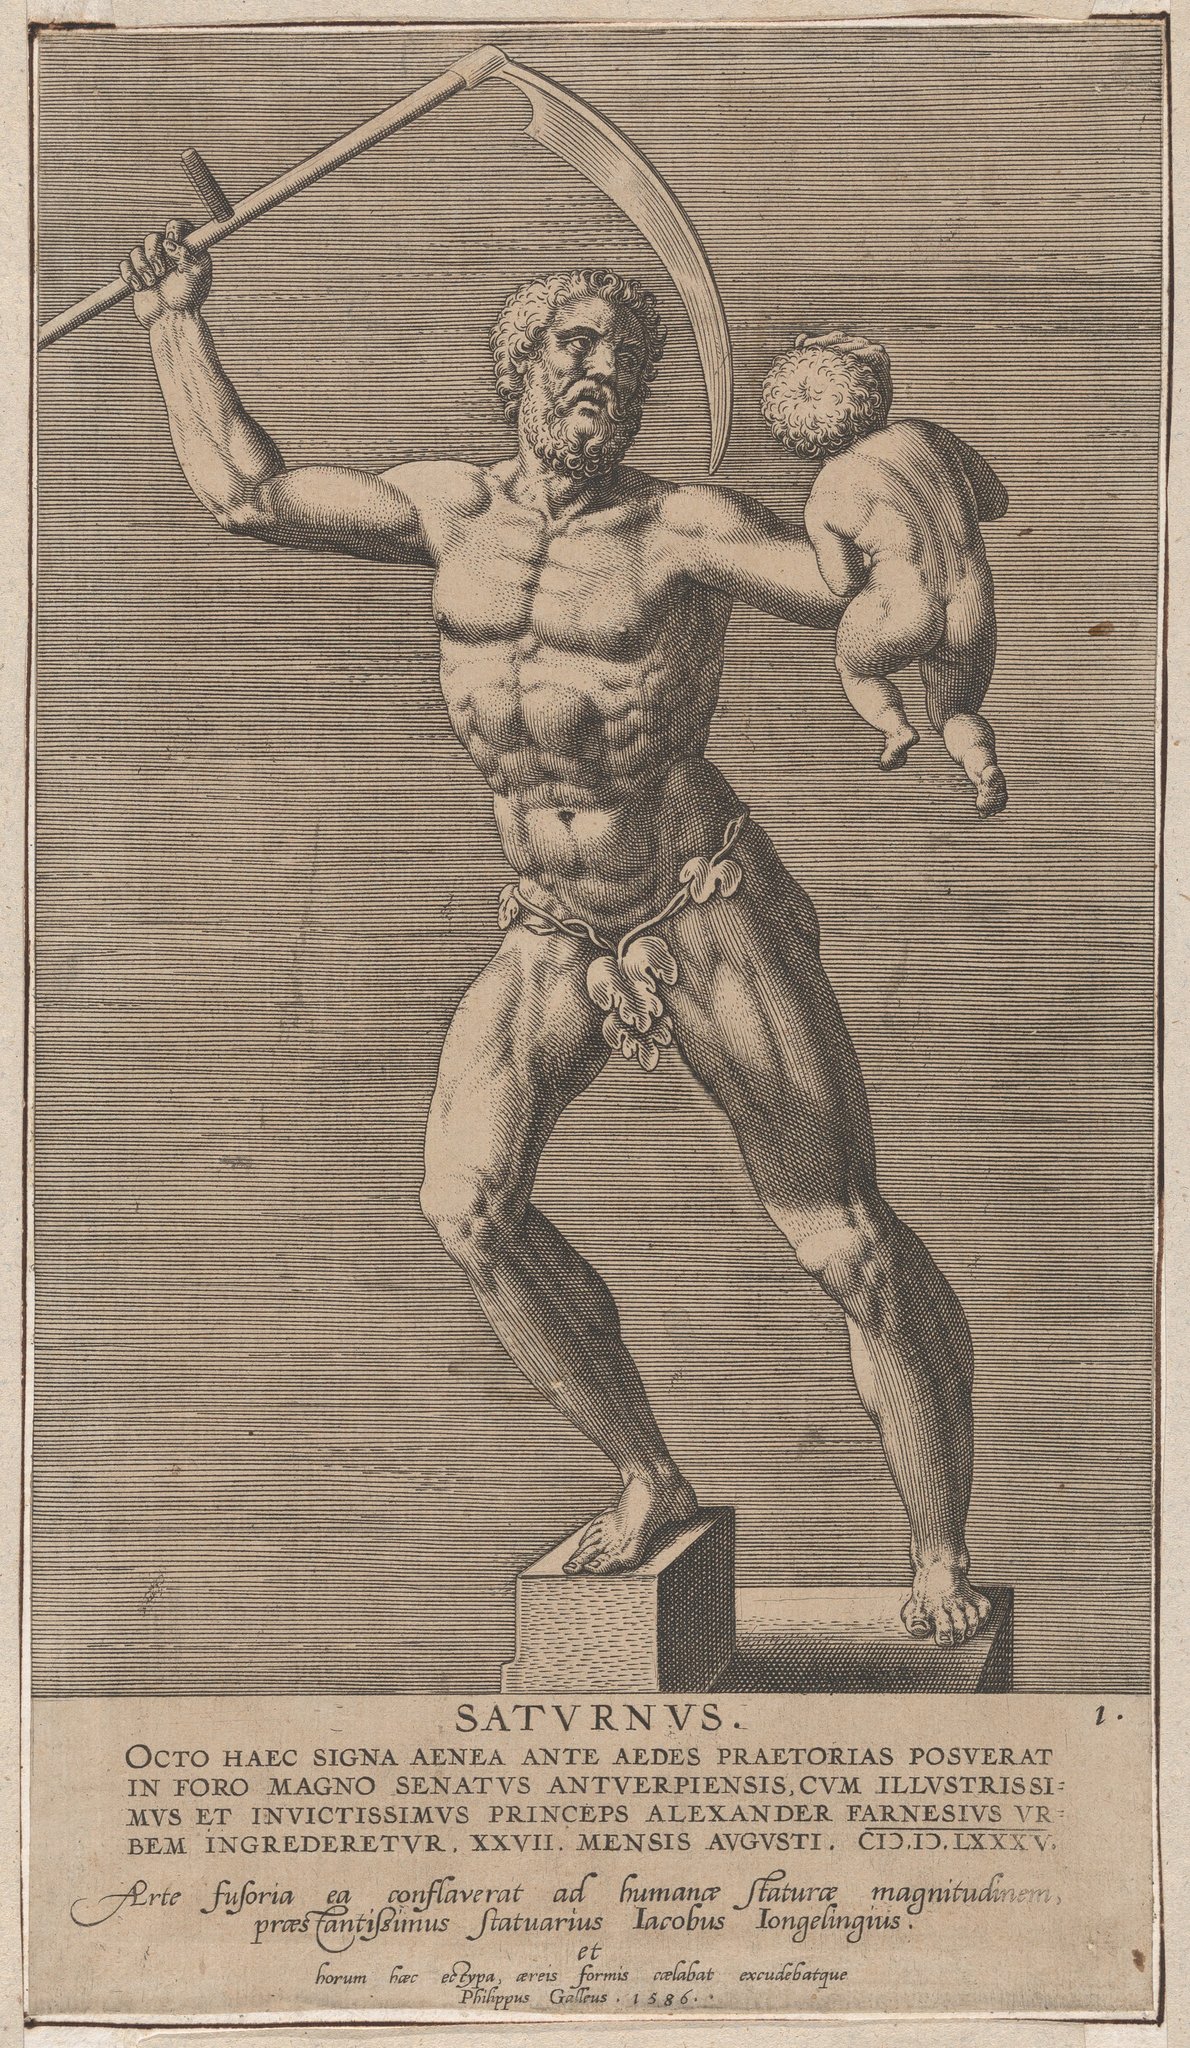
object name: print, fete, ornament architecture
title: Saturn; statue of the nude god standing on a socle, holding a scythe in his right hand and a child in his left, plate 1 from "Statues of Roman Gods"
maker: philips galle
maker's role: artist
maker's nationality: netherlandish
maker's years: 1537-1612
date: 1586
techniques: engraving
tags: sculpture,infants,saturn